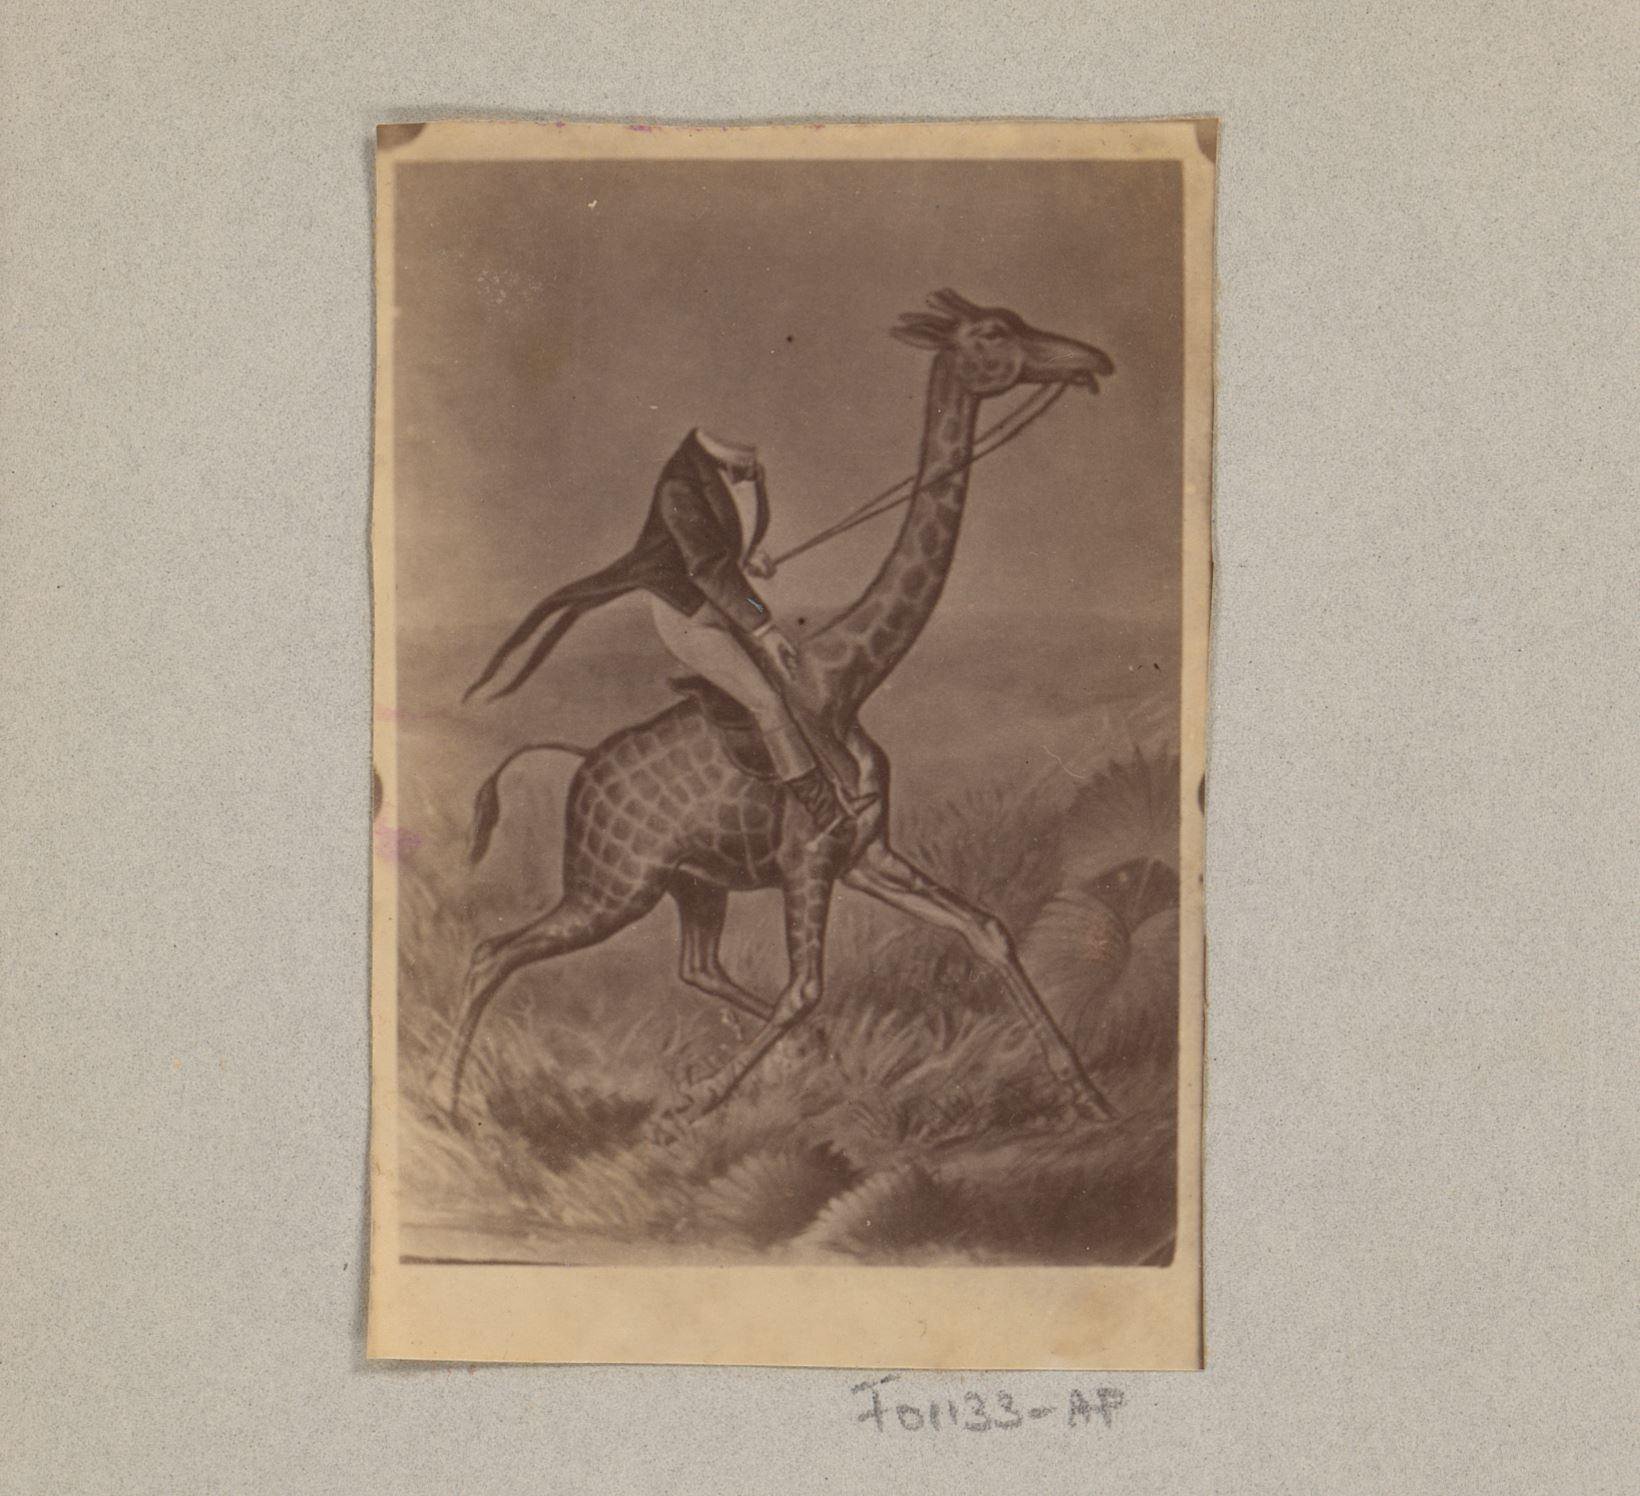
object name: album leaf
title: Fotoreproductie van een prent met een man zonder hoofd een giraffe berijdend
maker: marinus pieter filbri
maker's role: instrument maker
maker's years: 1852-1917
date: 1887-1888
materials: paper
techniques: albumen print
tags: riding on animal other than horse, ass, or mule, hoofed animals: giraffe